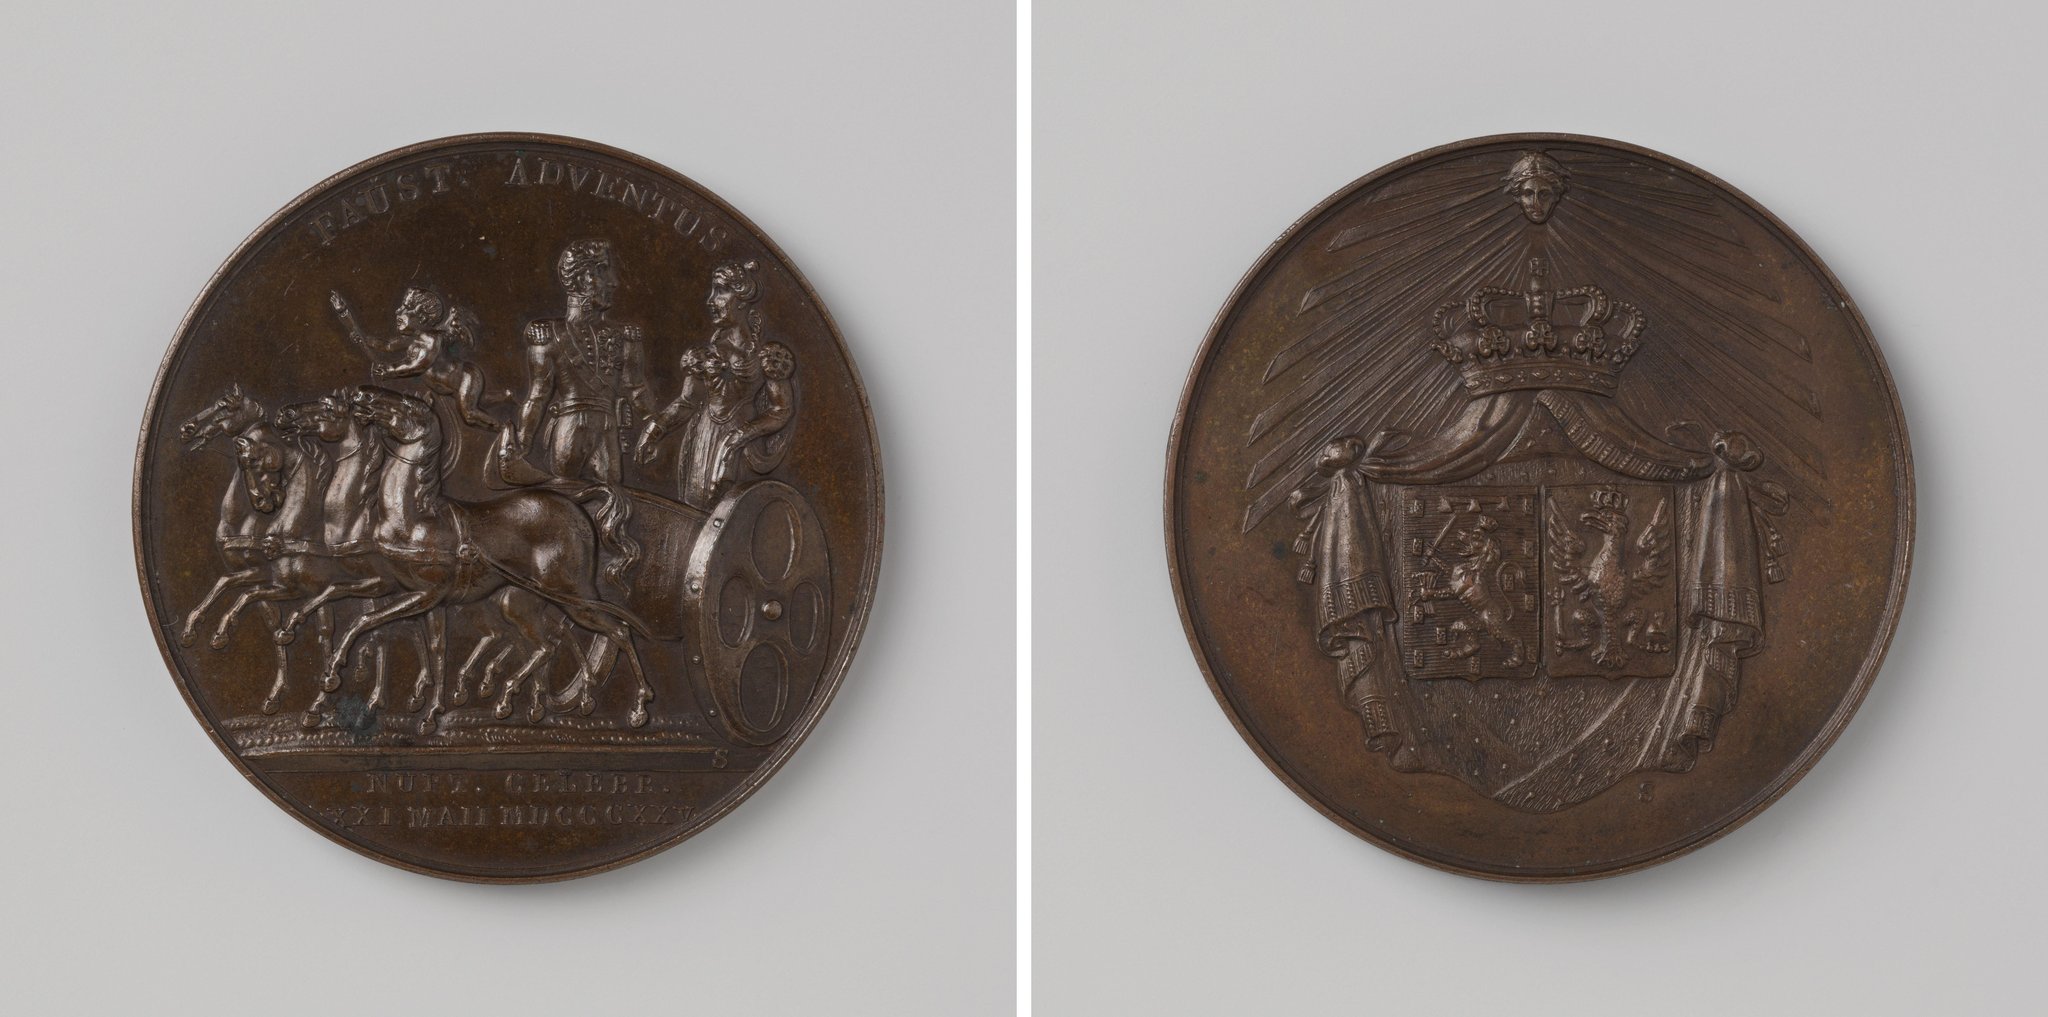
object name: history medal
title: Huwelijk van Frederik, prins der Nederlanden en Louise, prinses van Pruisen te Berlijn en hun aankomst in de Nederlanden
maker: jean henri simon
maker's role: medailleur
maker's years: 1752-1834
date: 1825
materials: bronze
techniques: striking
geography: brussels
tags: frederik (prins der nederlanden), netherlands, berlin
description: Bronzen penning. Voorzijde: man en vrouw, hand in hand staande op vierspan, dat gemend wordt door Amor met brandende huwelijkstoorts in hand binnen omschrift; afsnede: opschrift. Keerzijde: twee wapenschilden op hermelijnen mantel onder kroon, beschenen door stralend hoofd